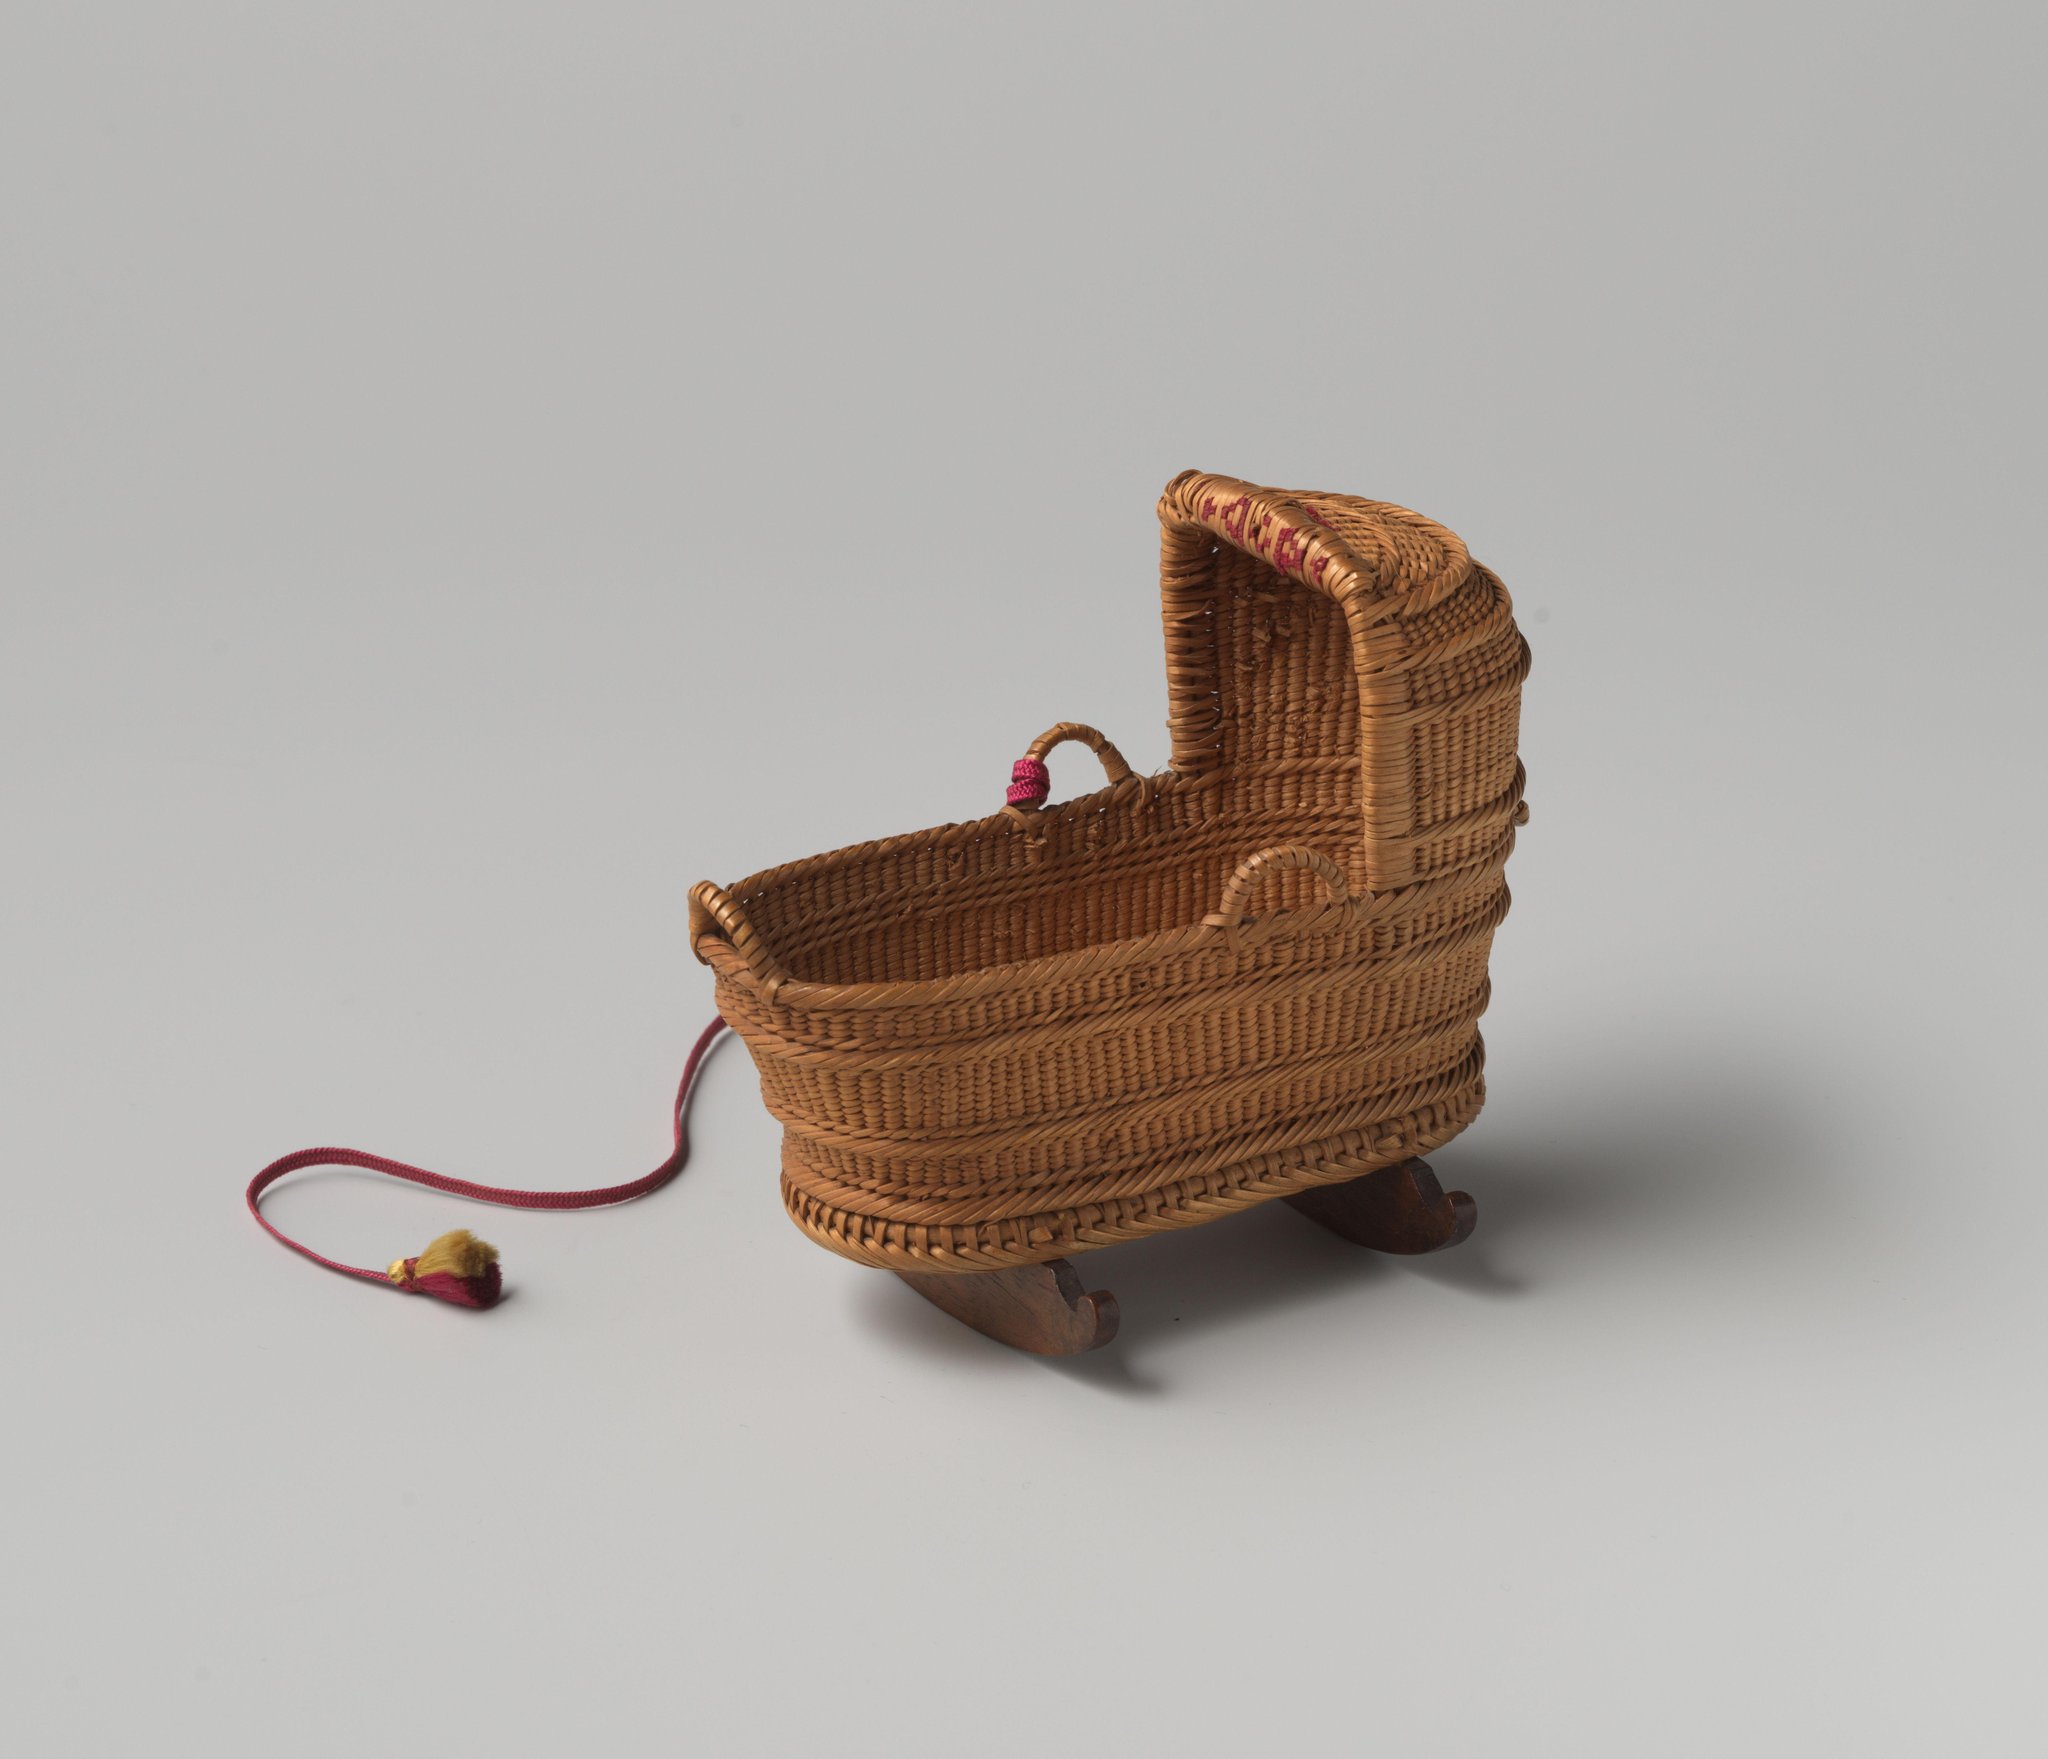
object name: wieg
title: Wieg, vervaardigd van gespleten wilgenteen, rustend op twee schenkels van notenhout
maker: Anonymous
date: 1690-1710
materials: copper, plant material, silk, wood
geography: amsterdam